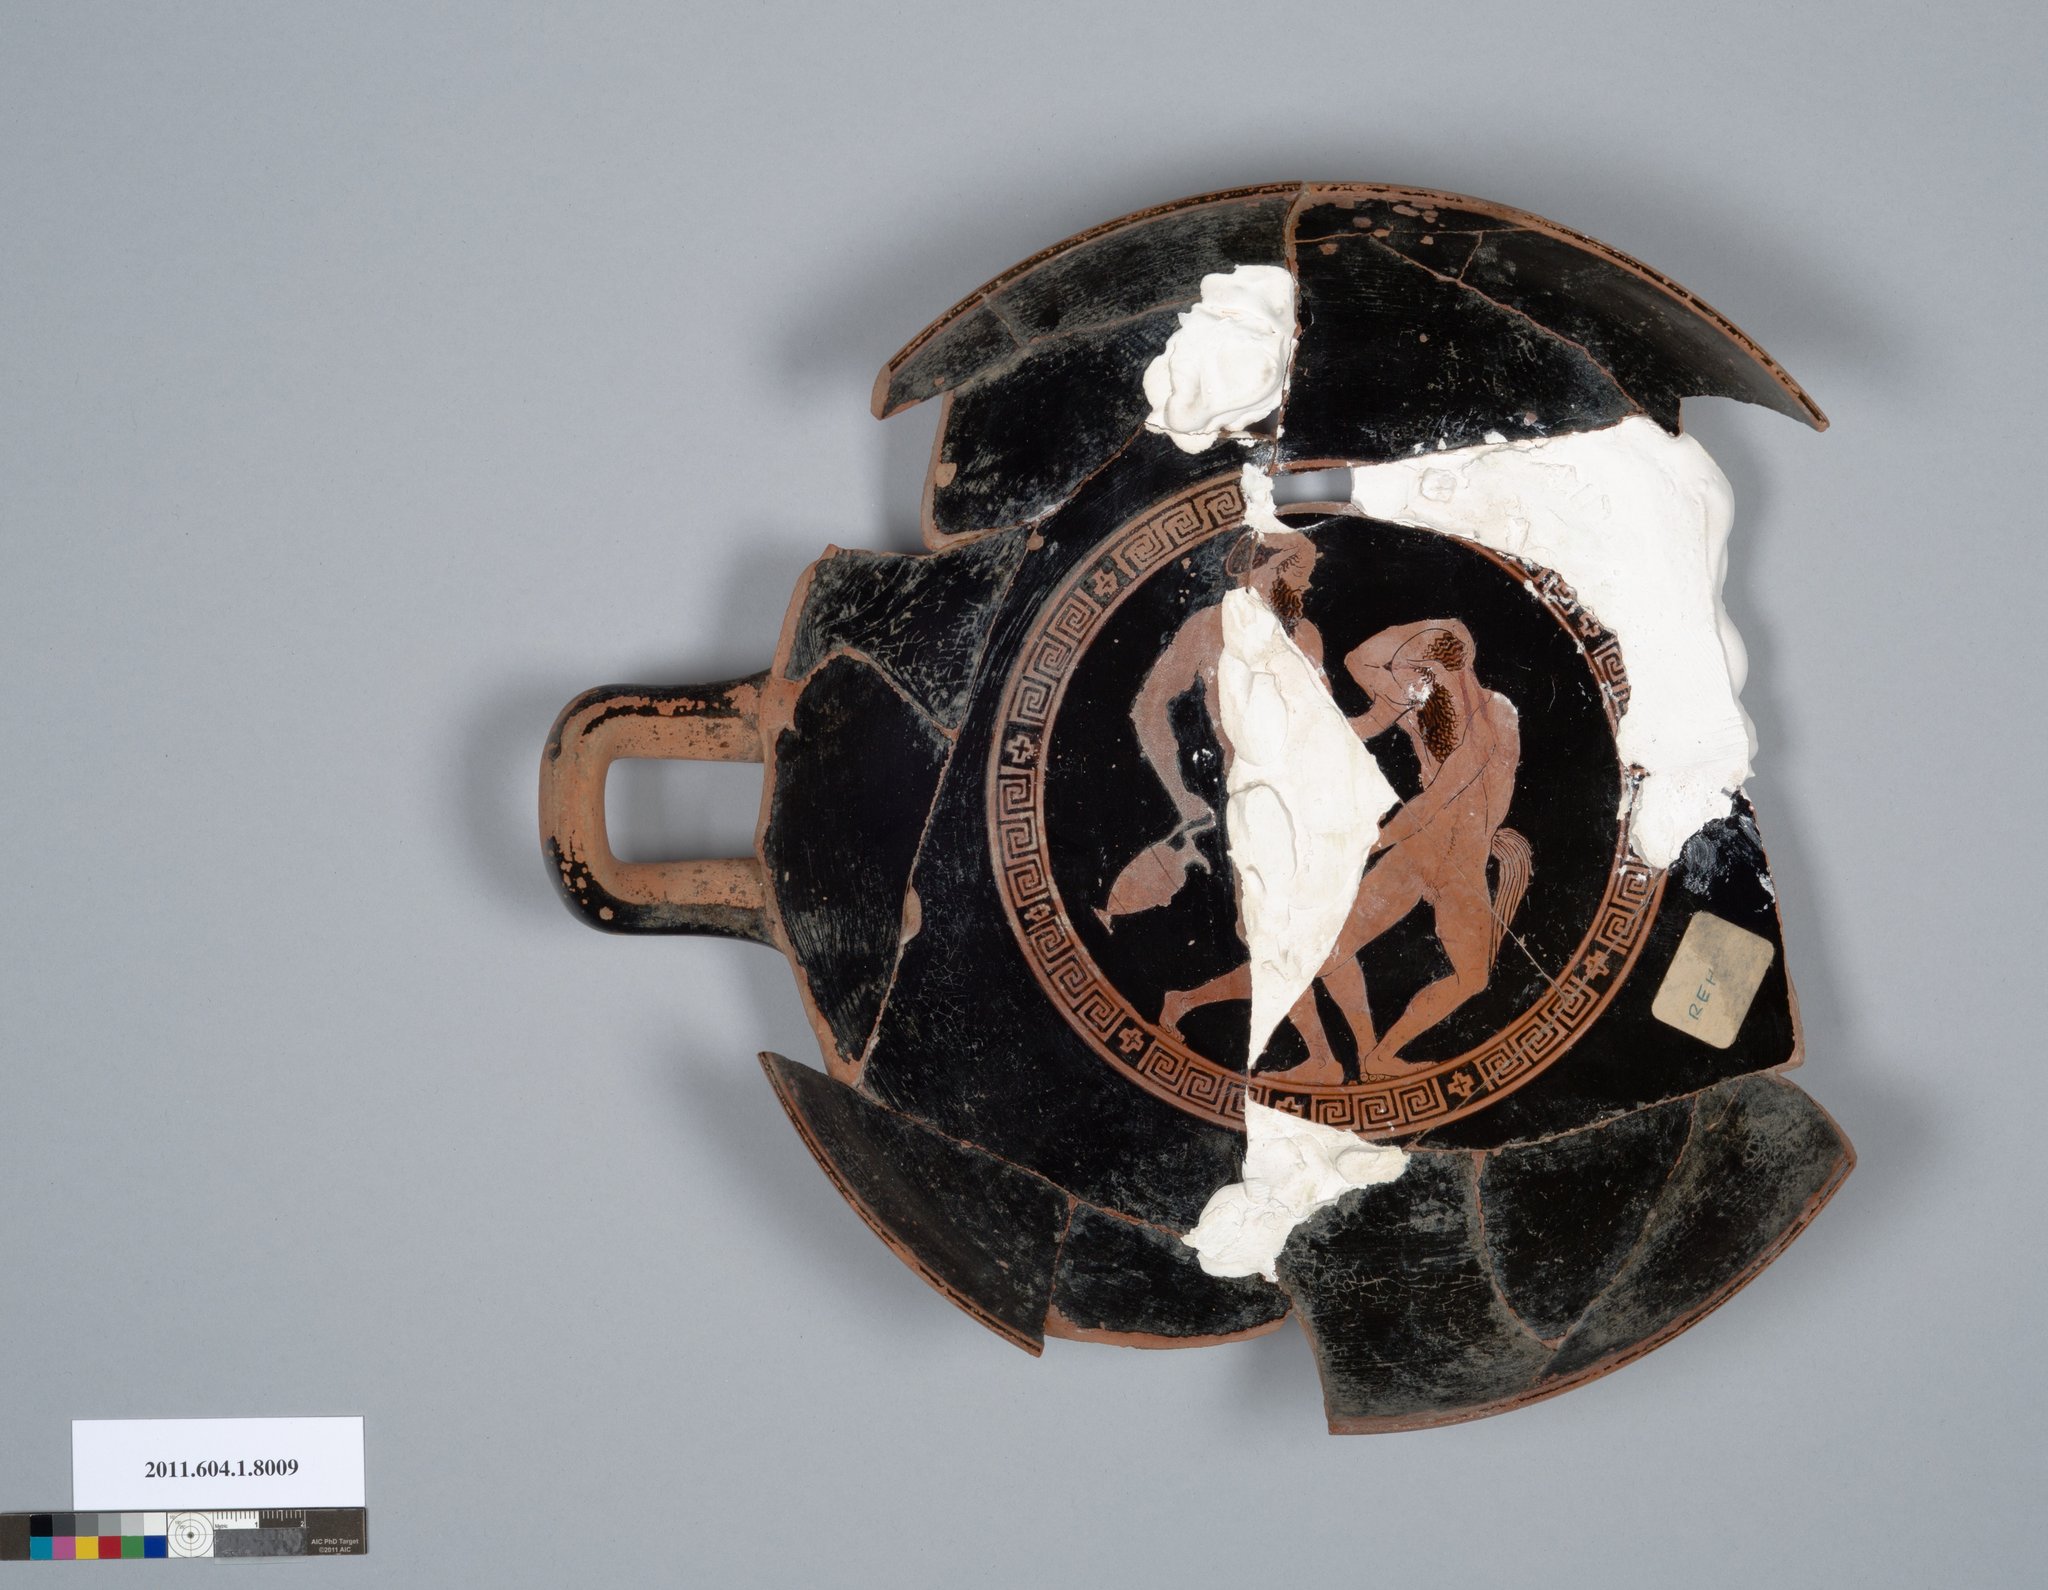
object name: kylix fragment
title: Terracotta fragment of a kylix (drinking cup)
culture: greek, attic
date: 460-450 BCE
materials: terracotta